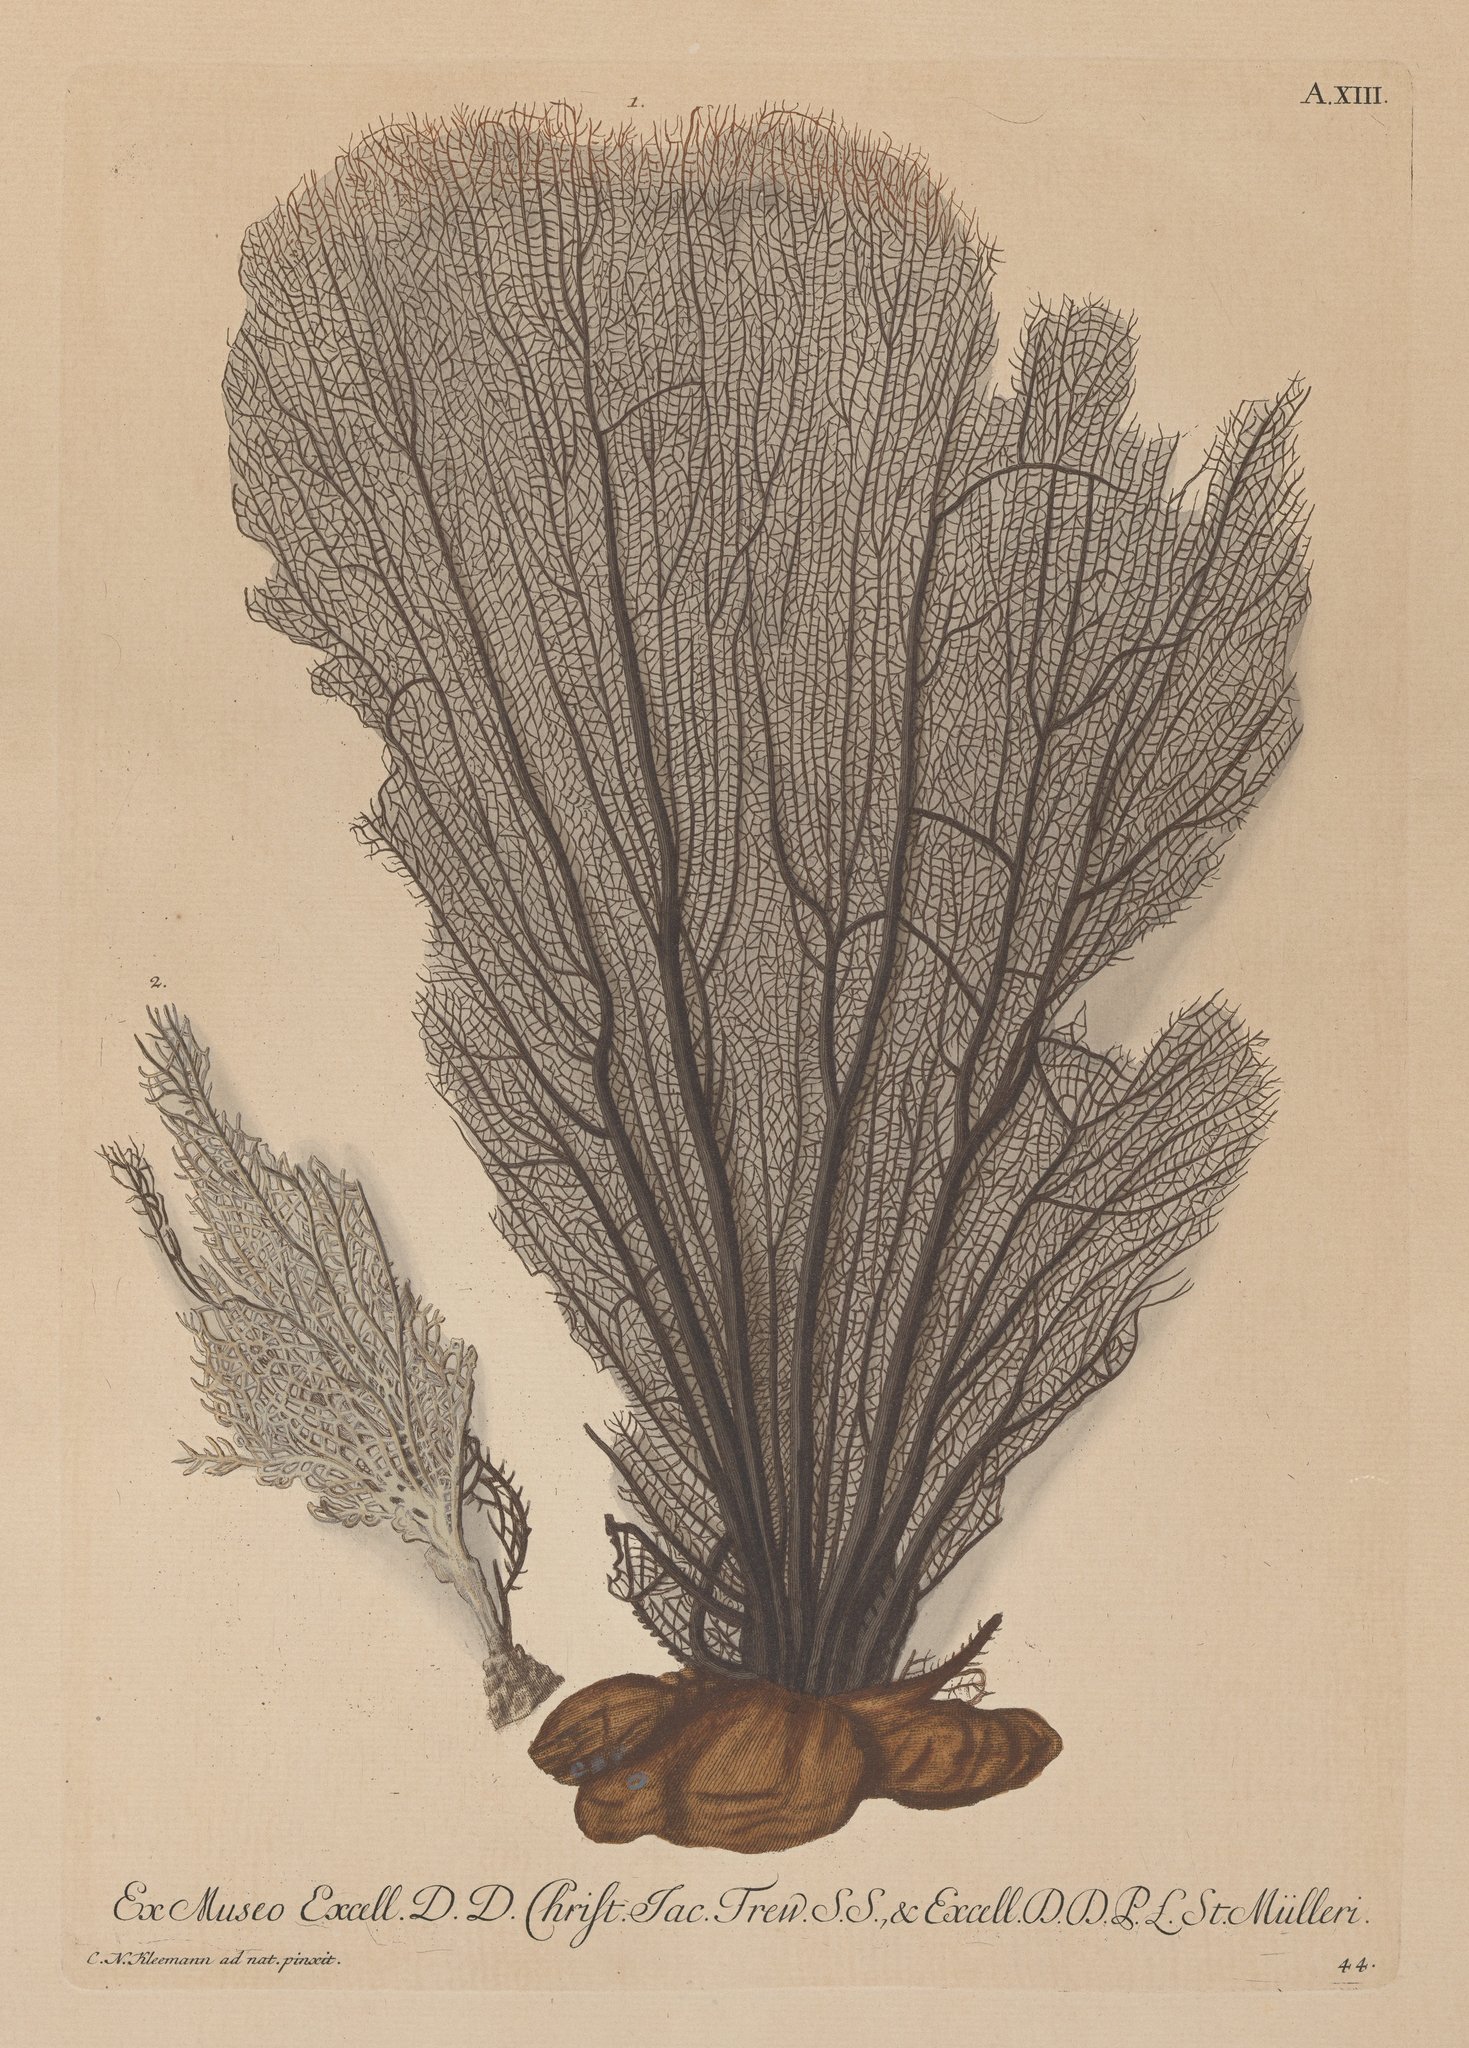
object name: print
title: Plate A. XIII, from "Deliciae Naturae Selectae"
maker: georg wolfgang knorr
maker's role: artist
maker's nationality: german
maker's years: 1705-1761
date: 1751-1767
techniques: engraving, hand coloring